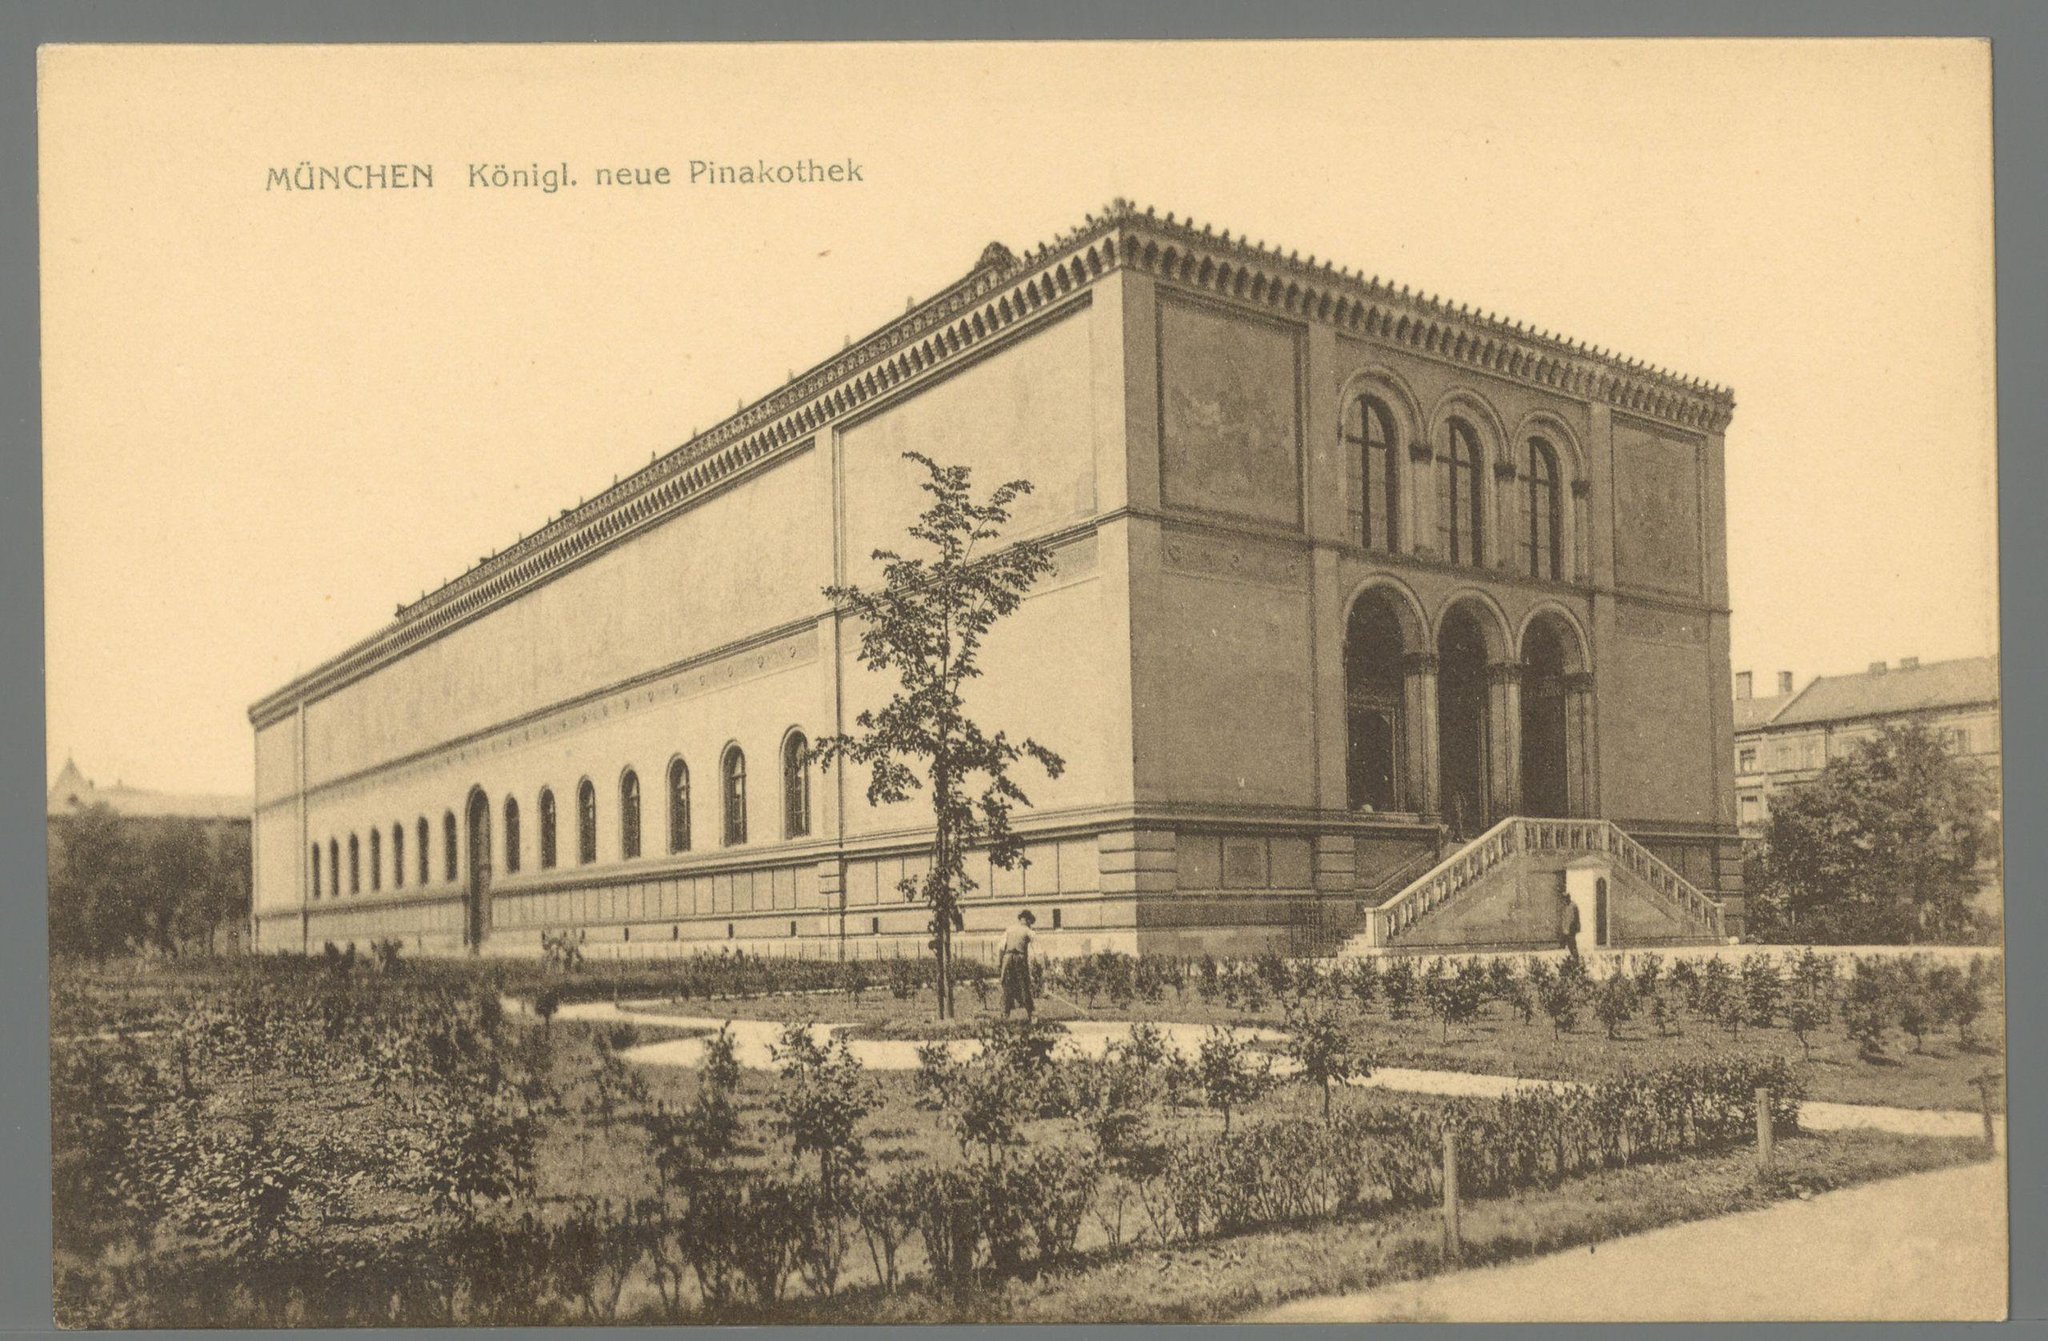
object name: ansichtkaart, prentbriefkaart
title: München. Königl. neue Pinakothek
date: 1905-1930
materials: cardboard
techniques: photograph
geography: munich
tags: permanent exhibition, museum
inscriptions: inscription: ‘W.H.D.’